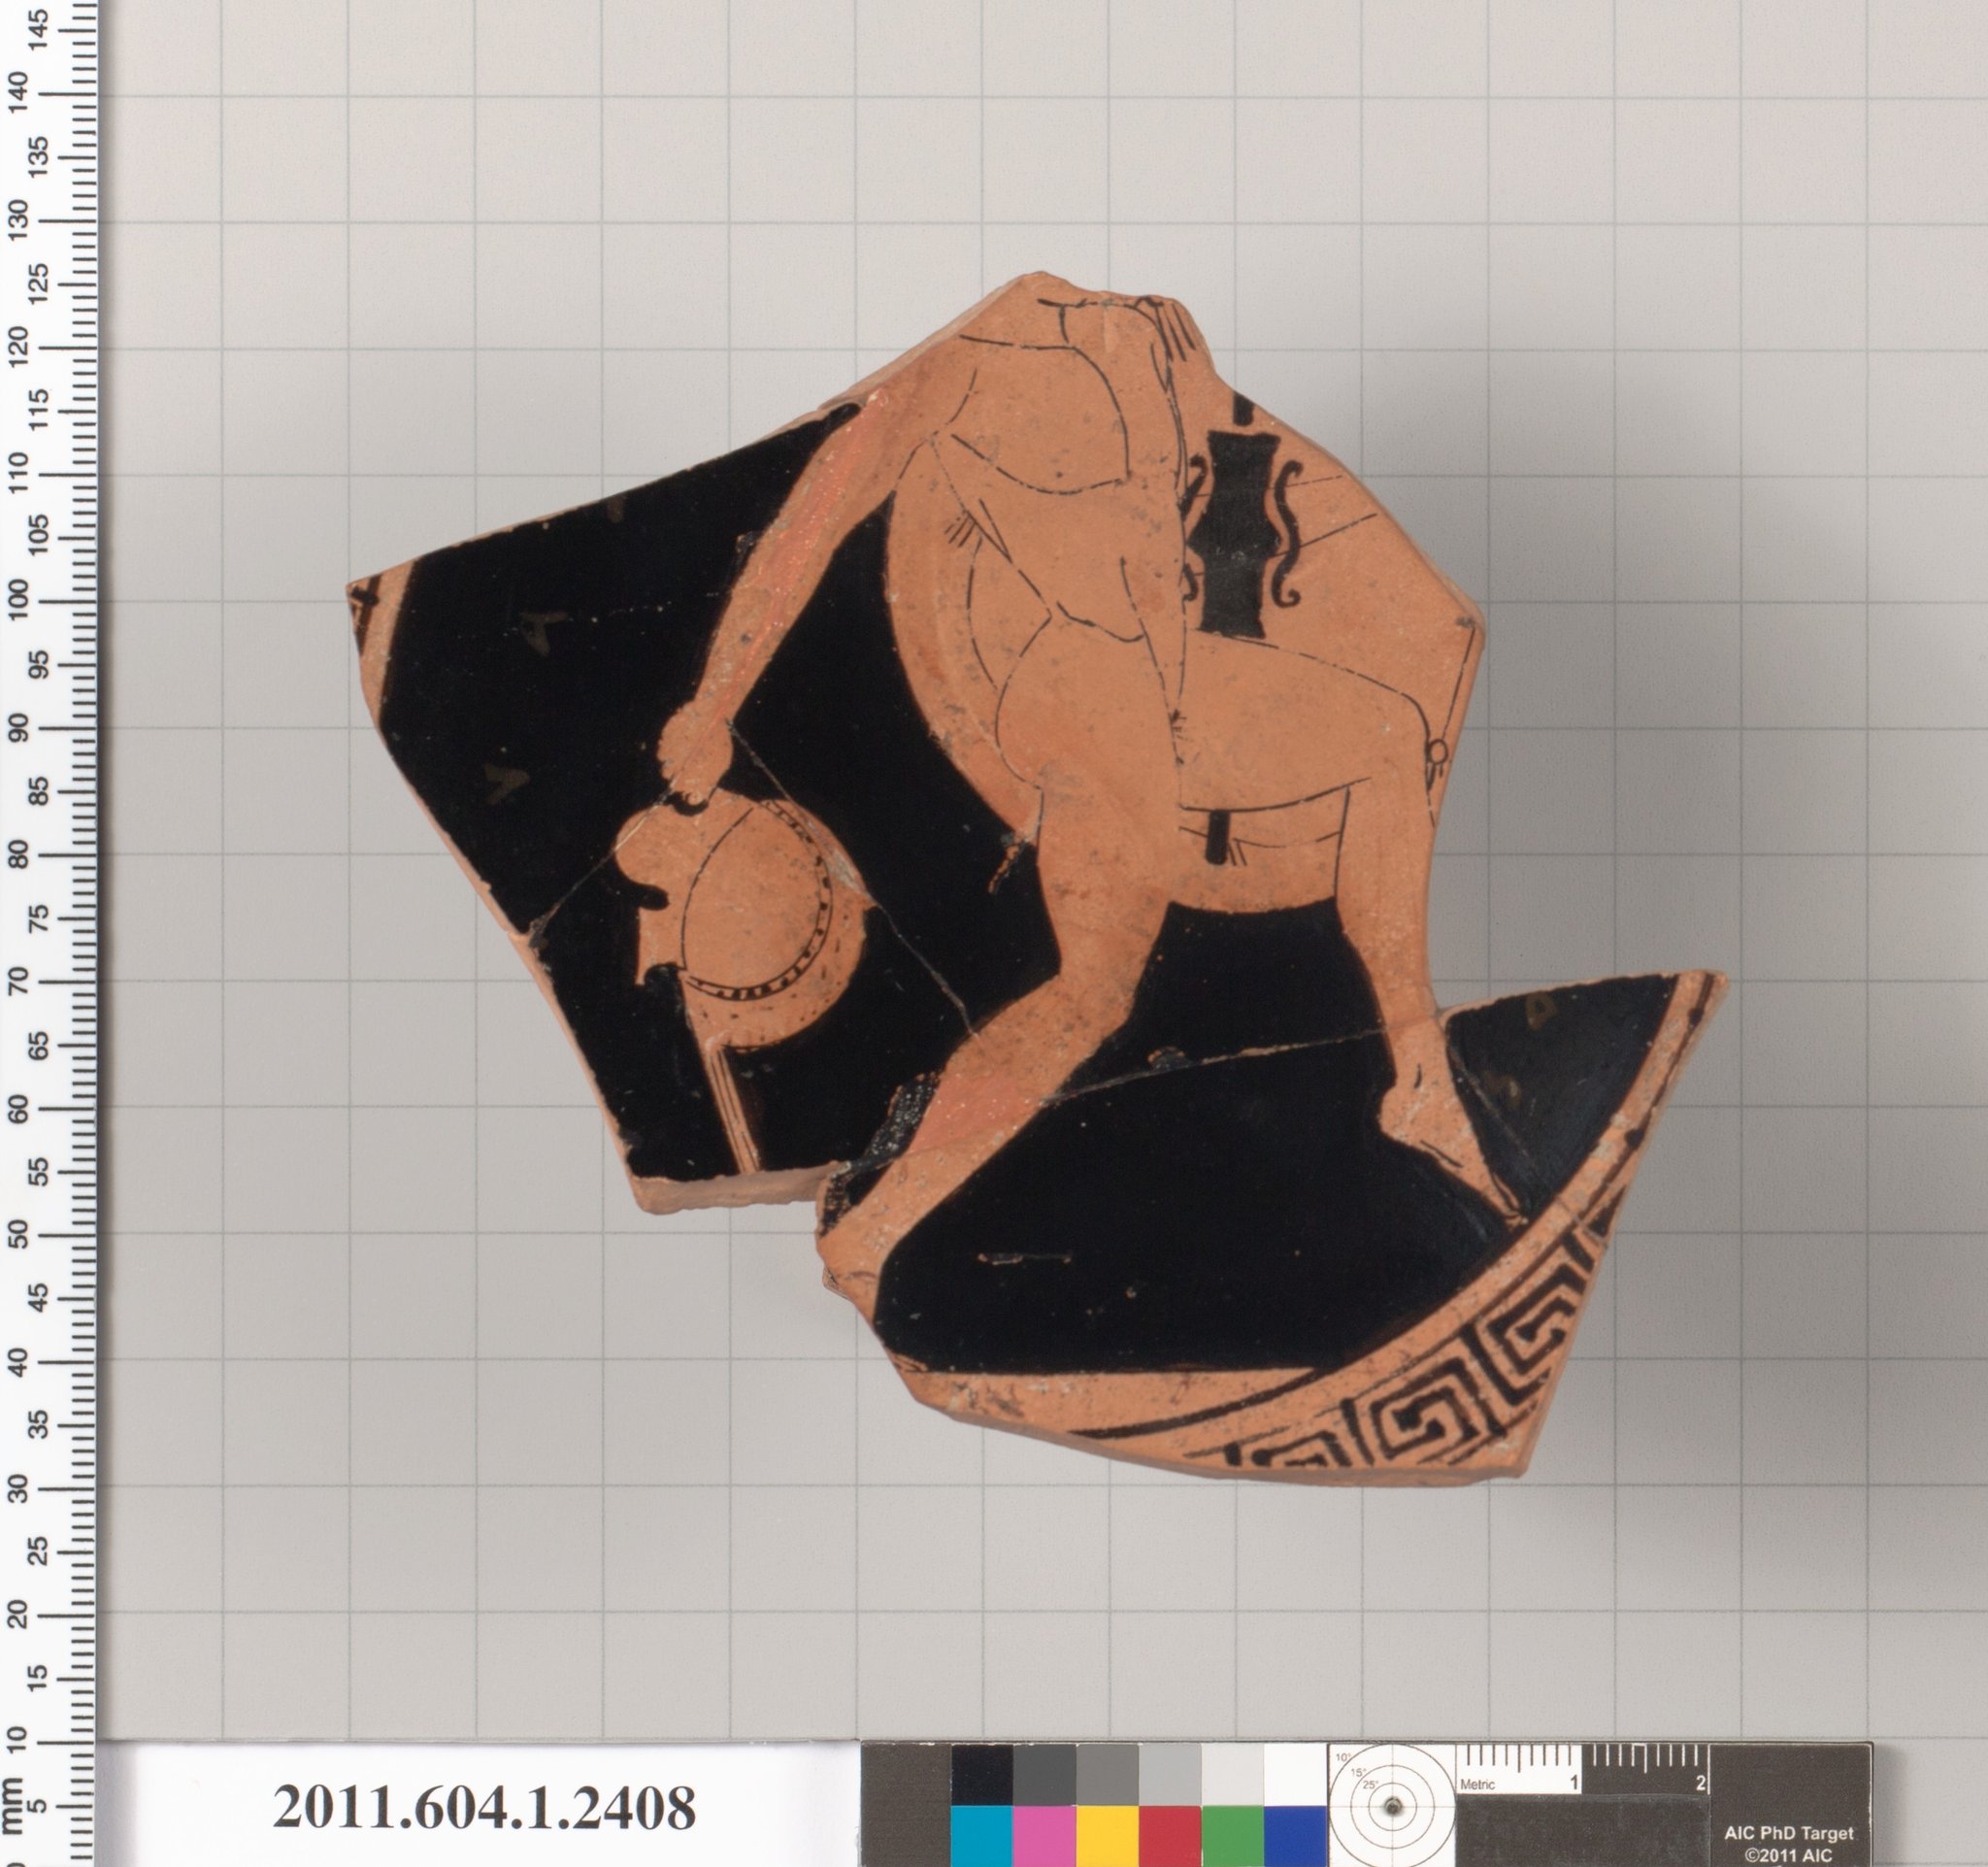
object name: kylix fragment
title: Terracotta fragment of a kylix (drinking cup)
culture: greek, attic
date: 490-480 BCE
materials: terracotta